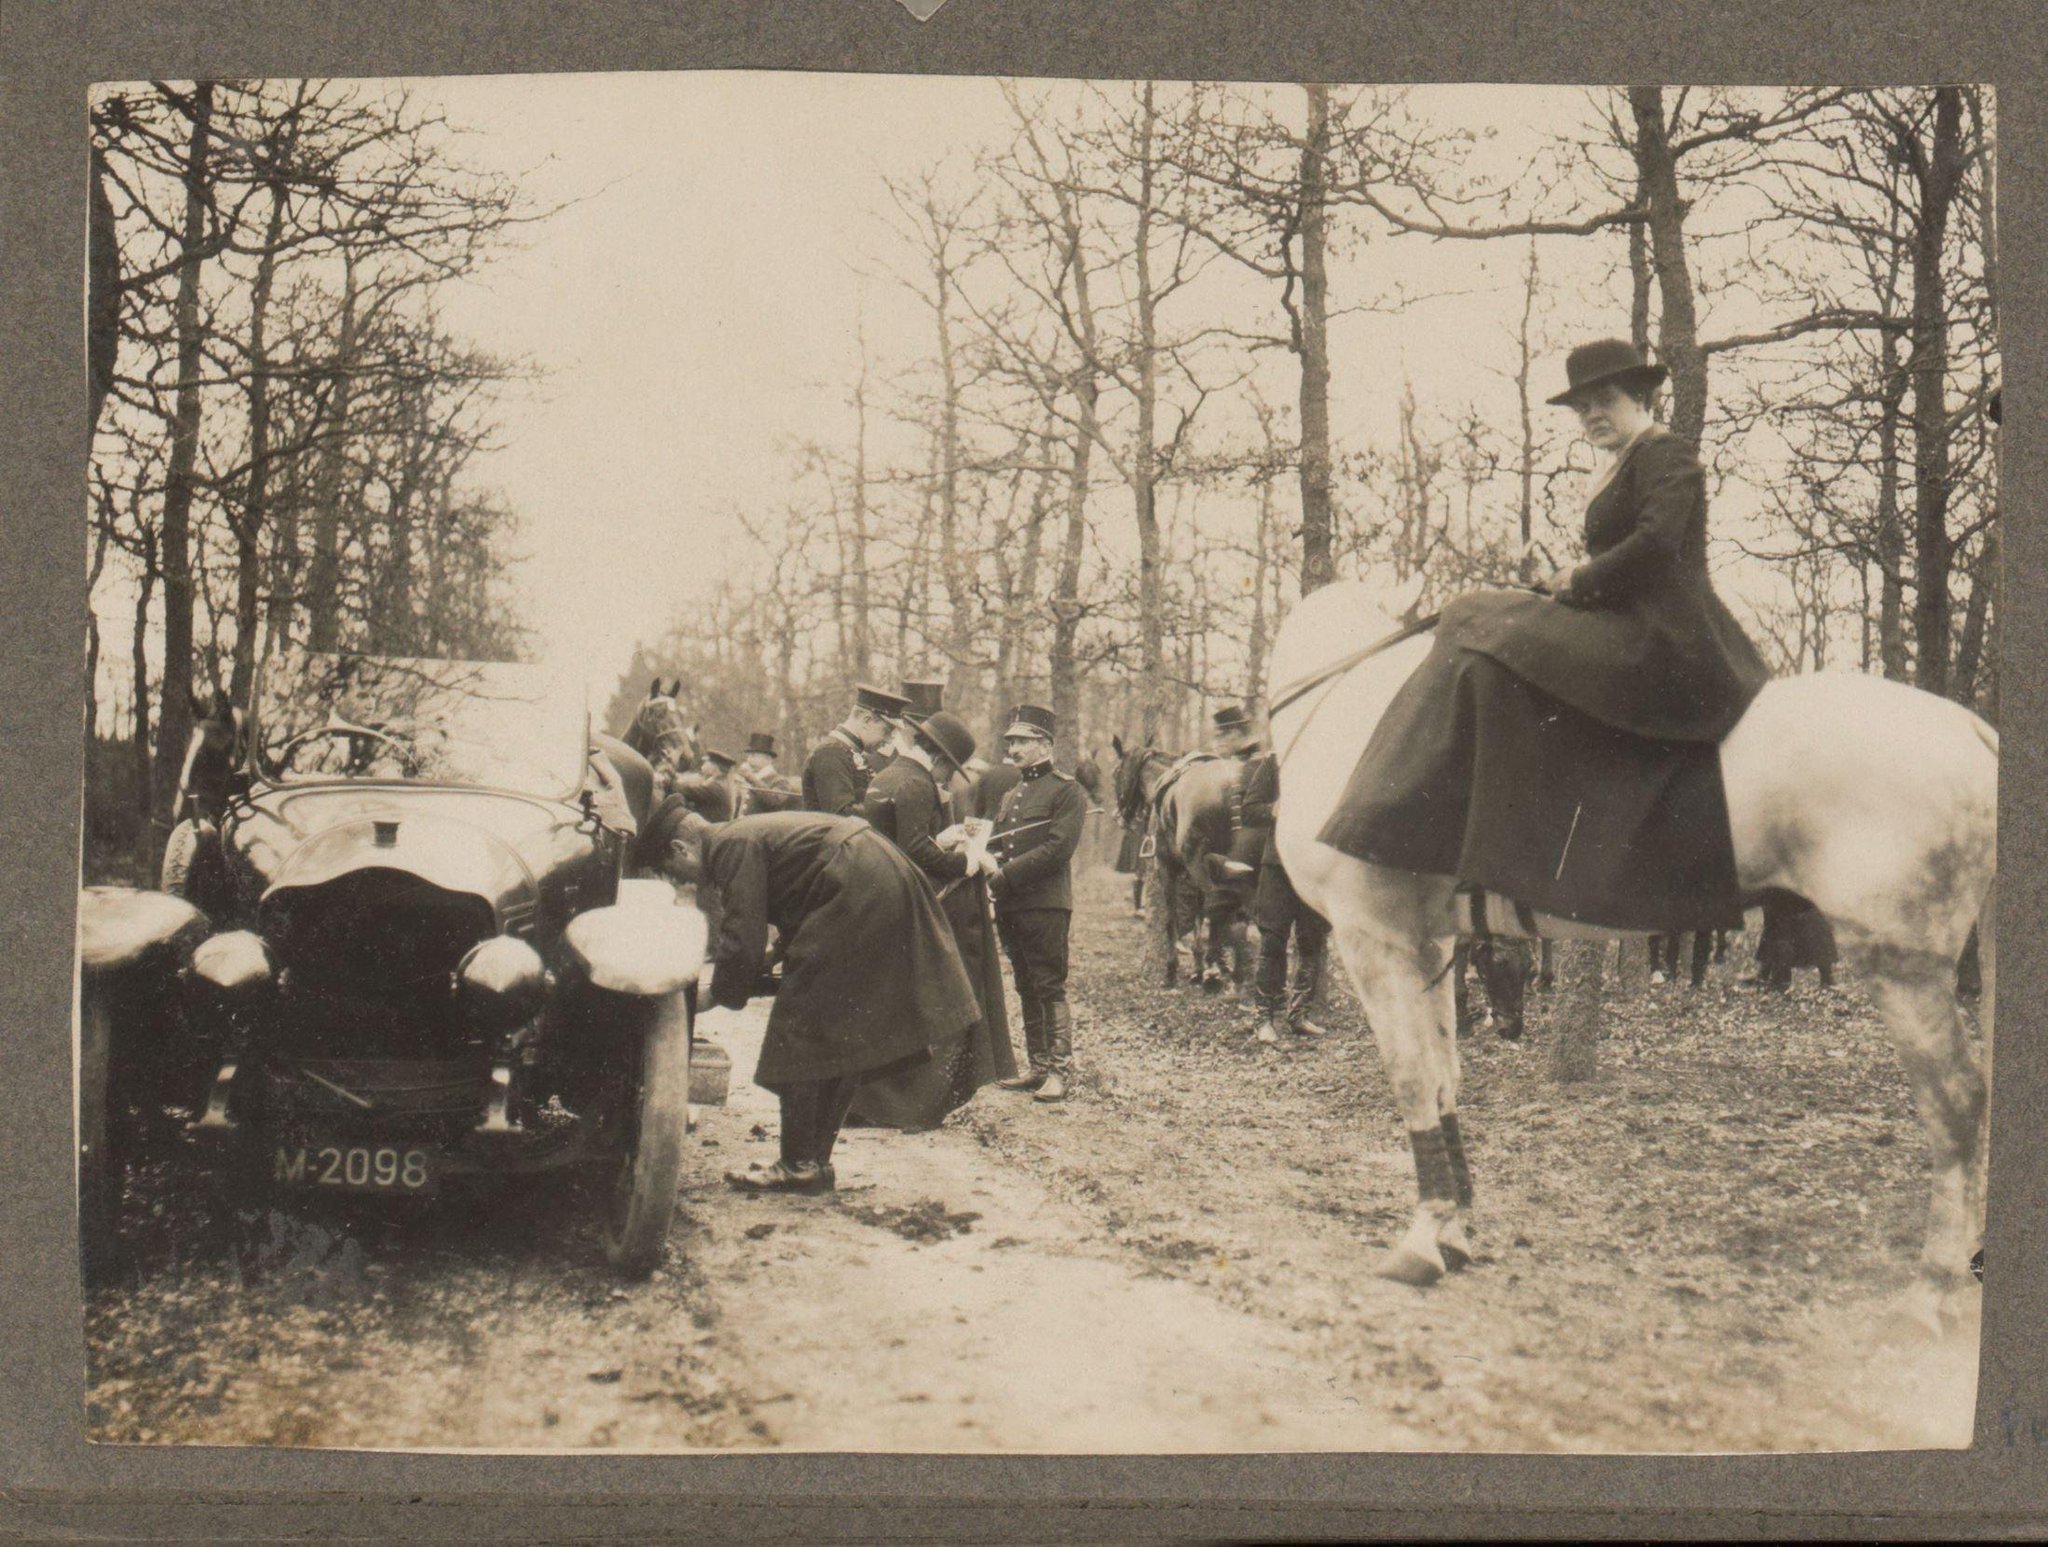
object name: photograph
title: Ruitertafereel op Koninklijke Houtvesterij Het Loo: publiek, vrouw te paard in amazonezit en auto op een landweg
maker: Anonymous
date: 1900-1925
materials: photographic support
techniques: gelatin silver print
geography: het loo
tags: riding a horse, ass, or mule; rider, horseman, hunting-ground, forest path or lane, automobile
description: Onderdeel van Fotoalbum van de heer Brams, opperhoutvester van koningin Wilhelmina op Koninklijke Houtvesterij Het Loo.